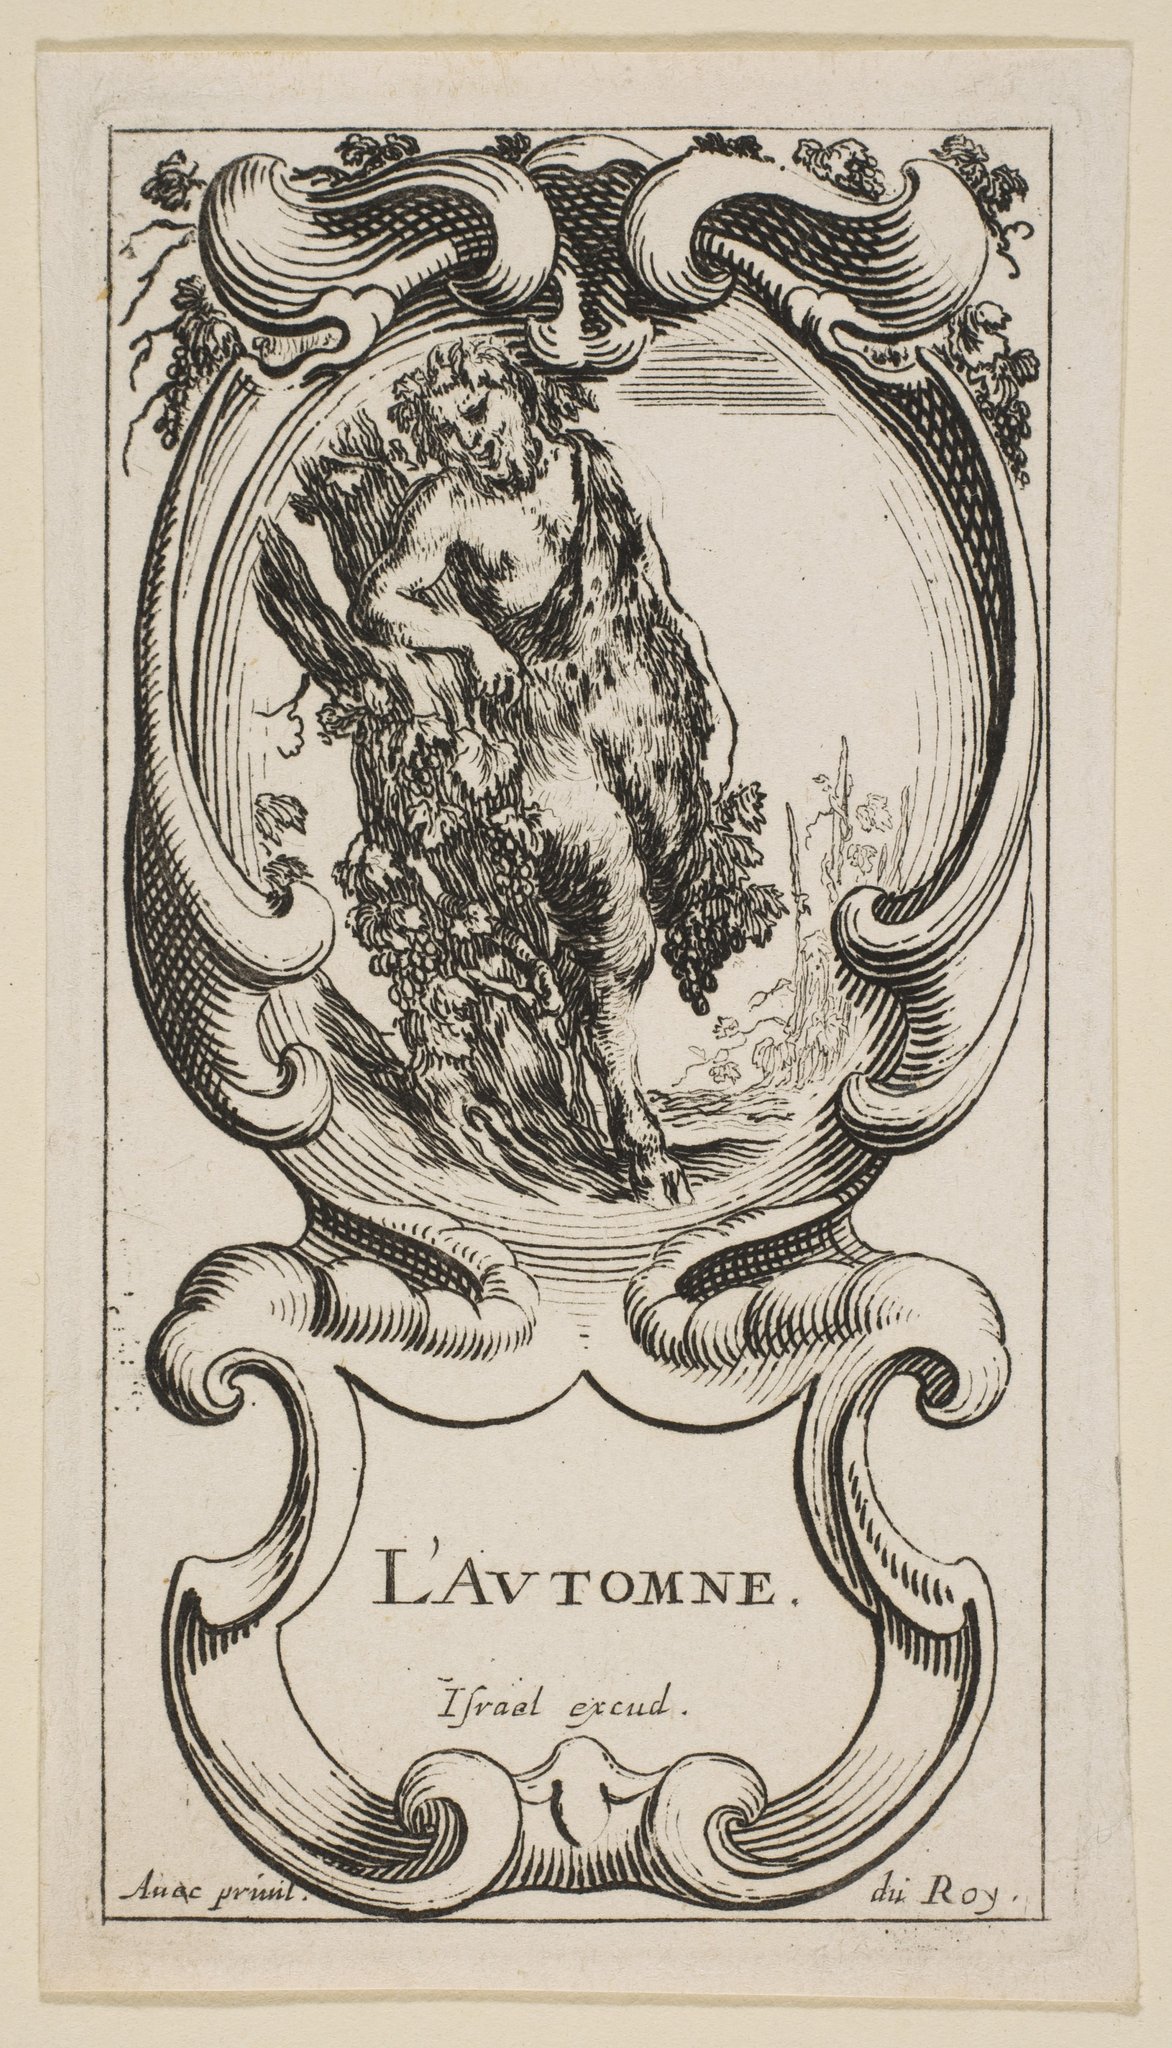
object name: print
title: Fall (L'Automne), from 'The Four Seasons'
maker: stefano della bella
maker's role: artist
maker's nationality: italian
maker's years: 1610-1664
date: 1641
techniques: etching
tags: grapes,satyrs